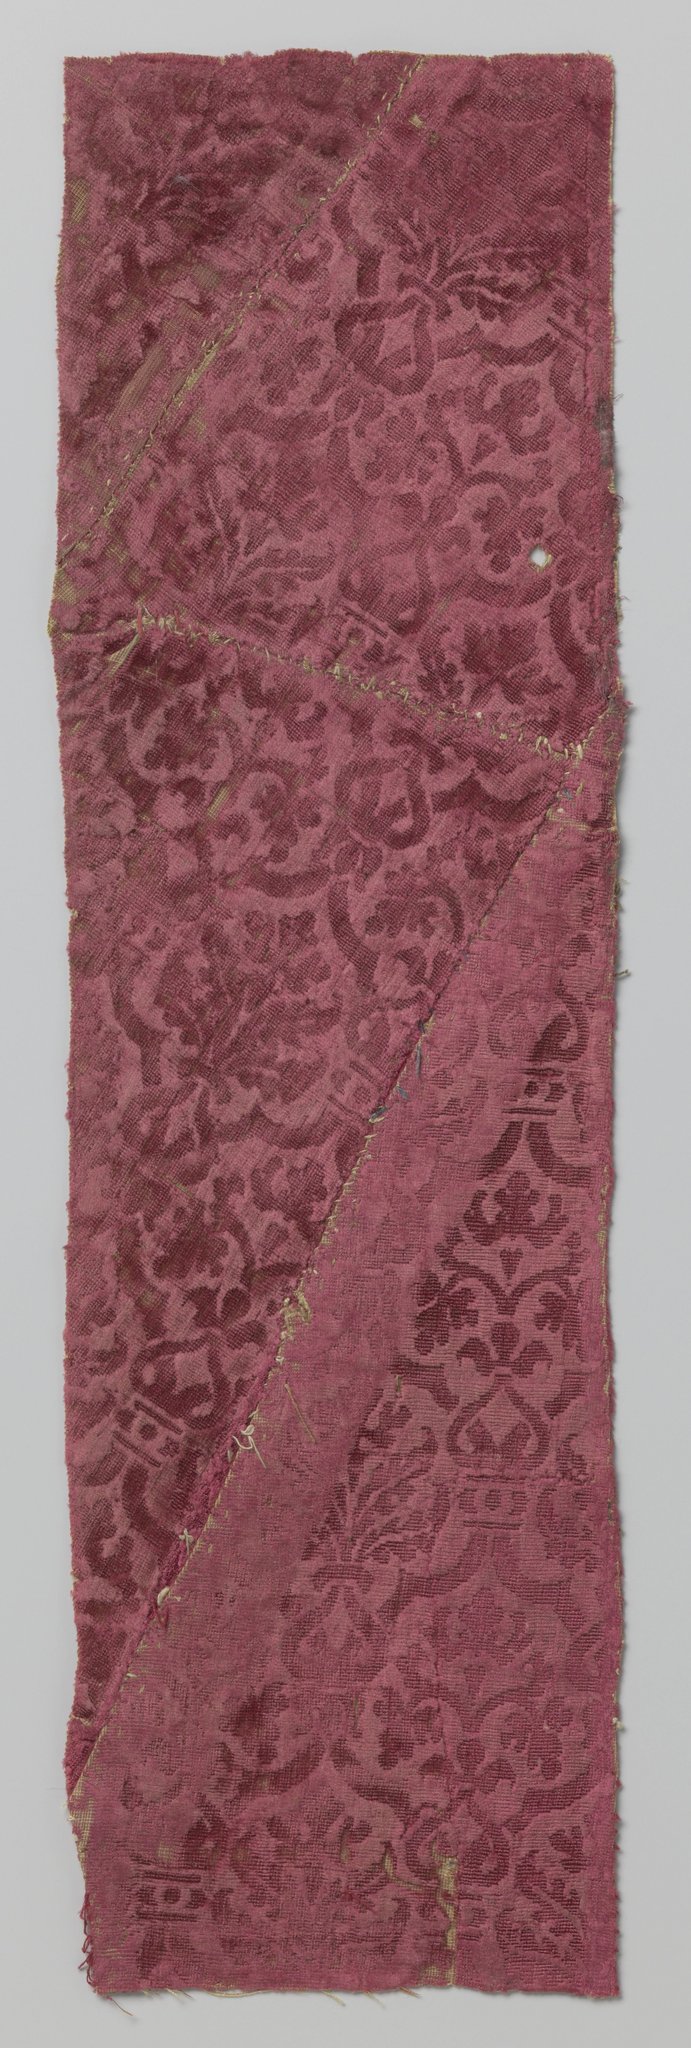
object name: fragment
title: Fragment rood zijden fluweel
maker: Anonymous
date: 1500-1599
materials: ciselé velvet, silk, velvet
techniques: weave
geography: italy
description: Fragment rood zijden ciselé fluweel. Het patroon heeft palmet-medaillons.